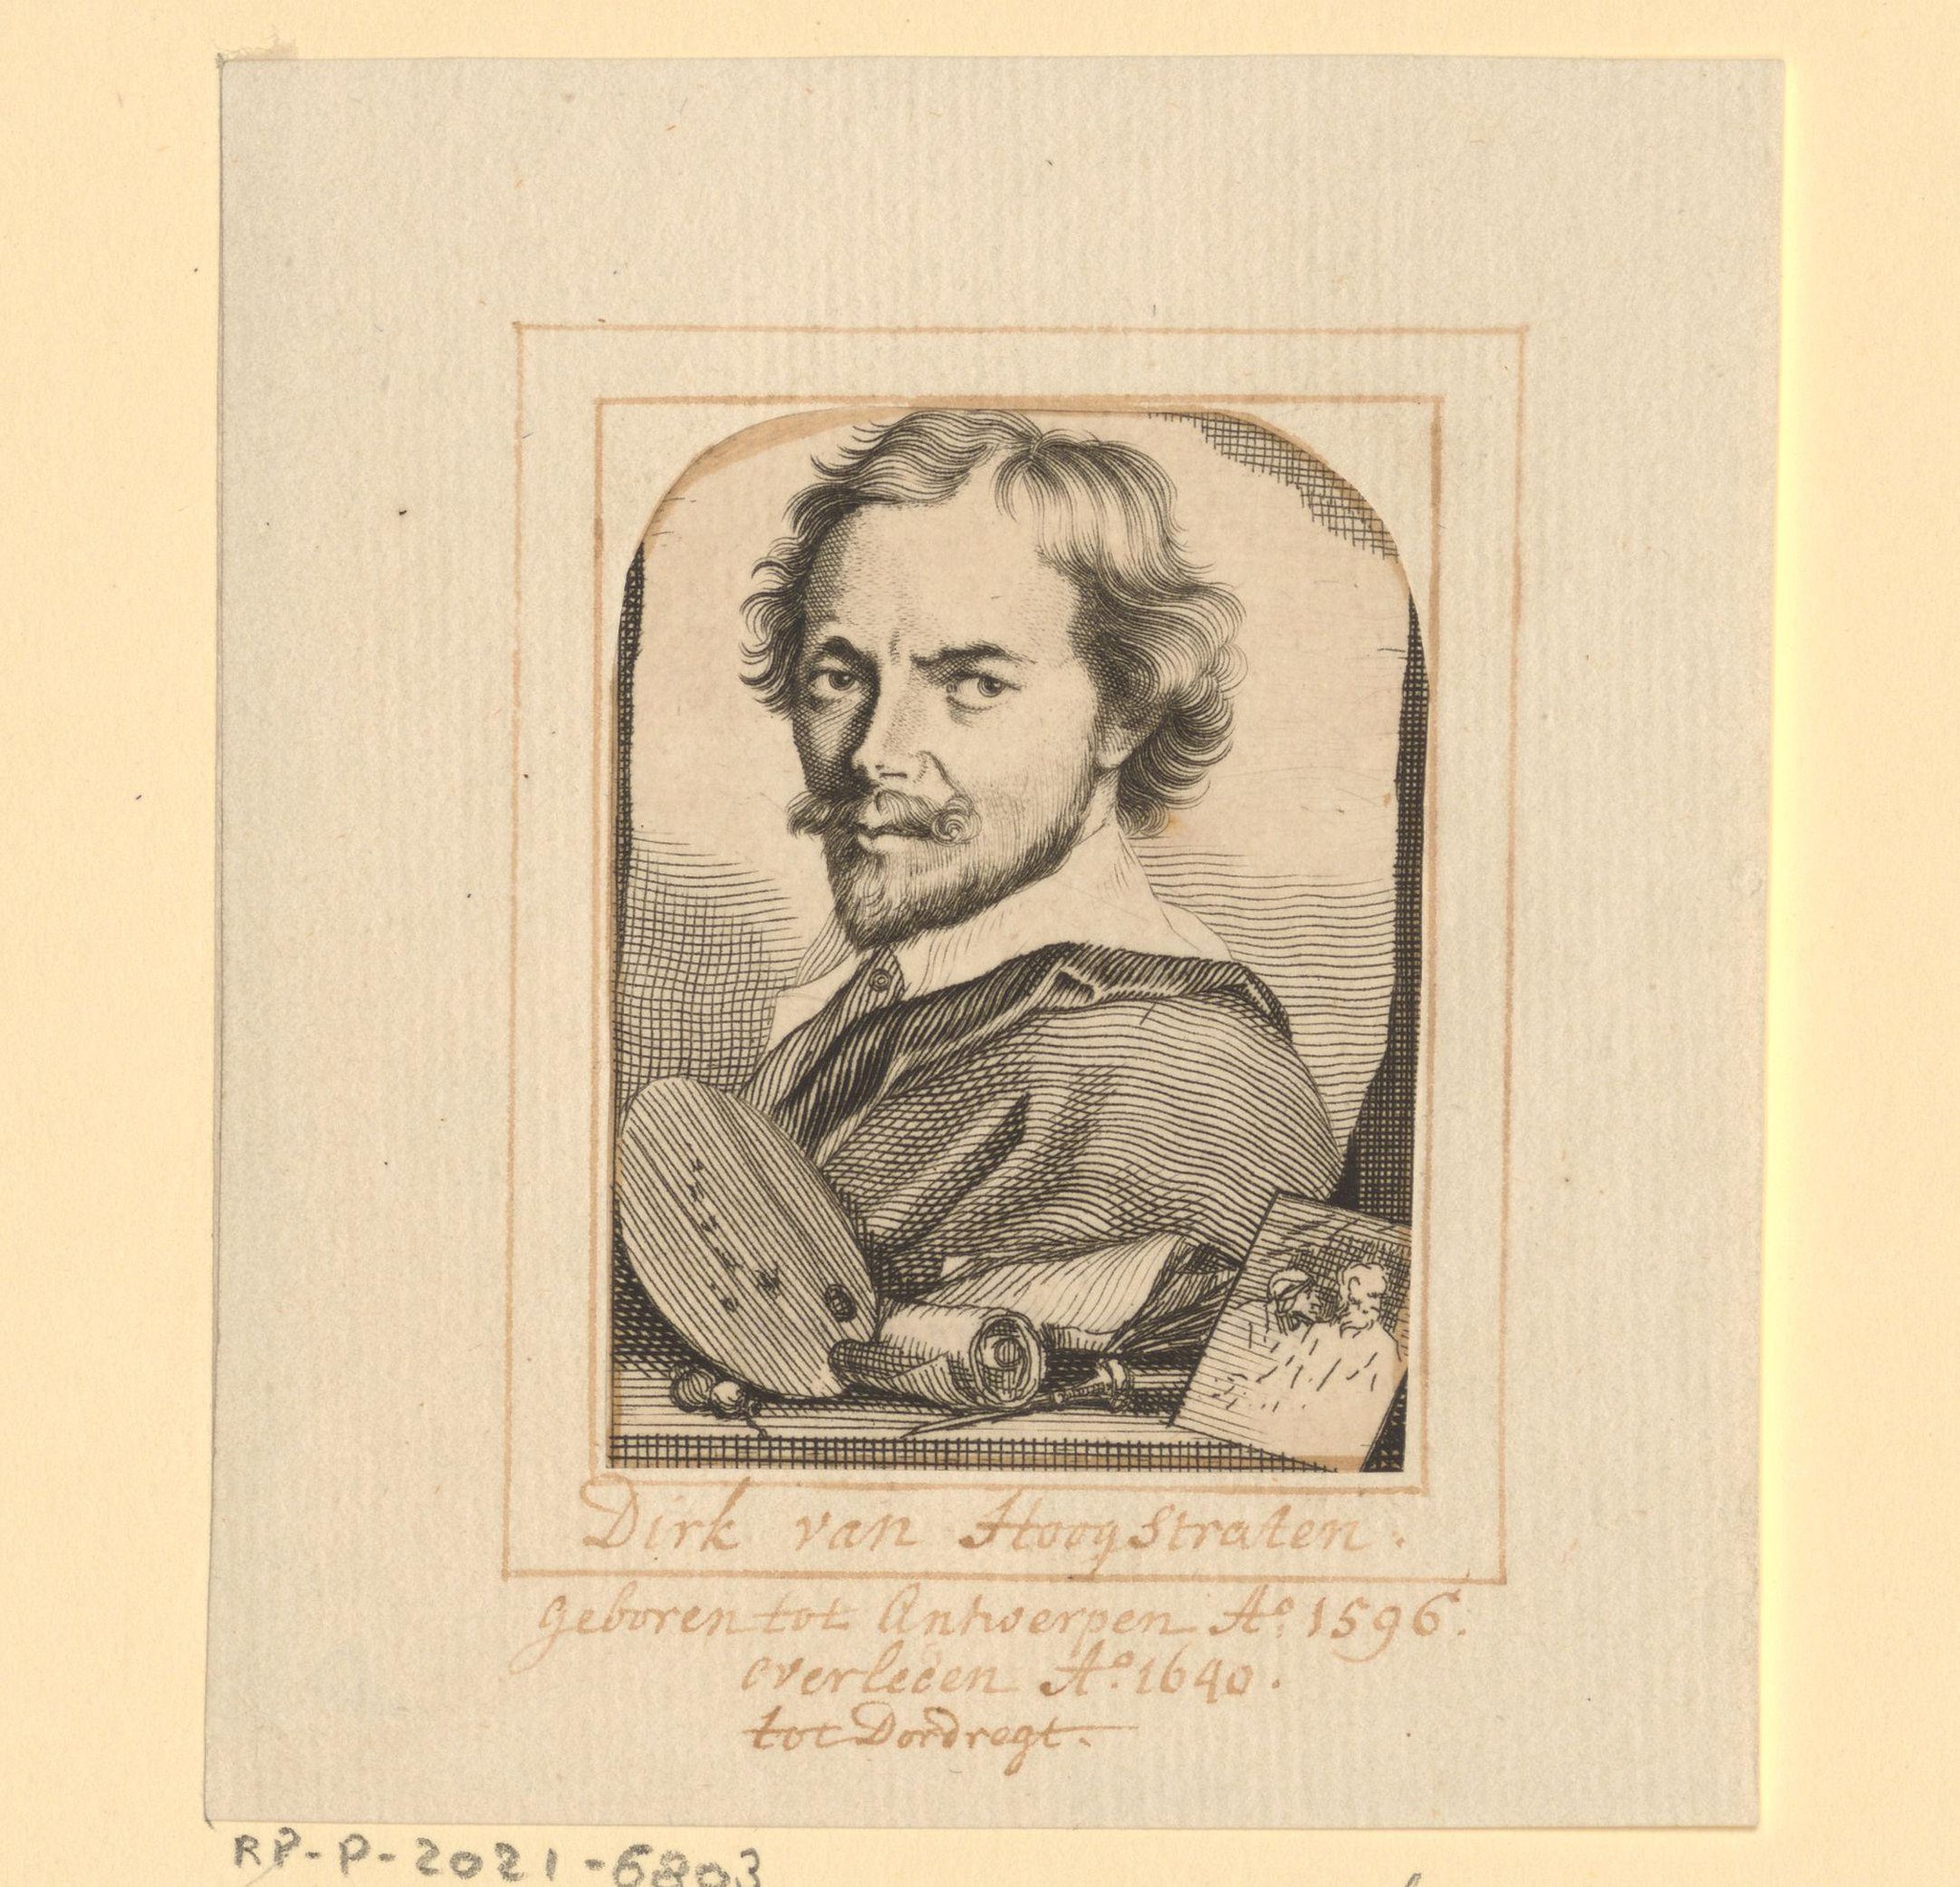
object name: print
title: Portret van Dirk van Hoogstraten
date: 1718-1753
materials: paper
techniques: engraving, etching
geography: amsterdam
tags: antwerp, dordrecht, painter, print maker, dirk van hoogstraten, historical persons, portrait, self-portrait of painter, tools, implements of painter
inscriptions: inscription: ‘Dirk van Hoogstraten./ geboren tot Antwerpen a[nn]o 1596./ overleden a[nn]o 1640./ tot Dordregt.’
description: Prent uit: Houbraken, Arnold. De groote schouburgh der Nederlantsche konstschilders en schilderessen (...). Amsterdam: Arnold Houbraken, 1718, dl. 1. Prent ook gebruikt in latere edities van dit werk.